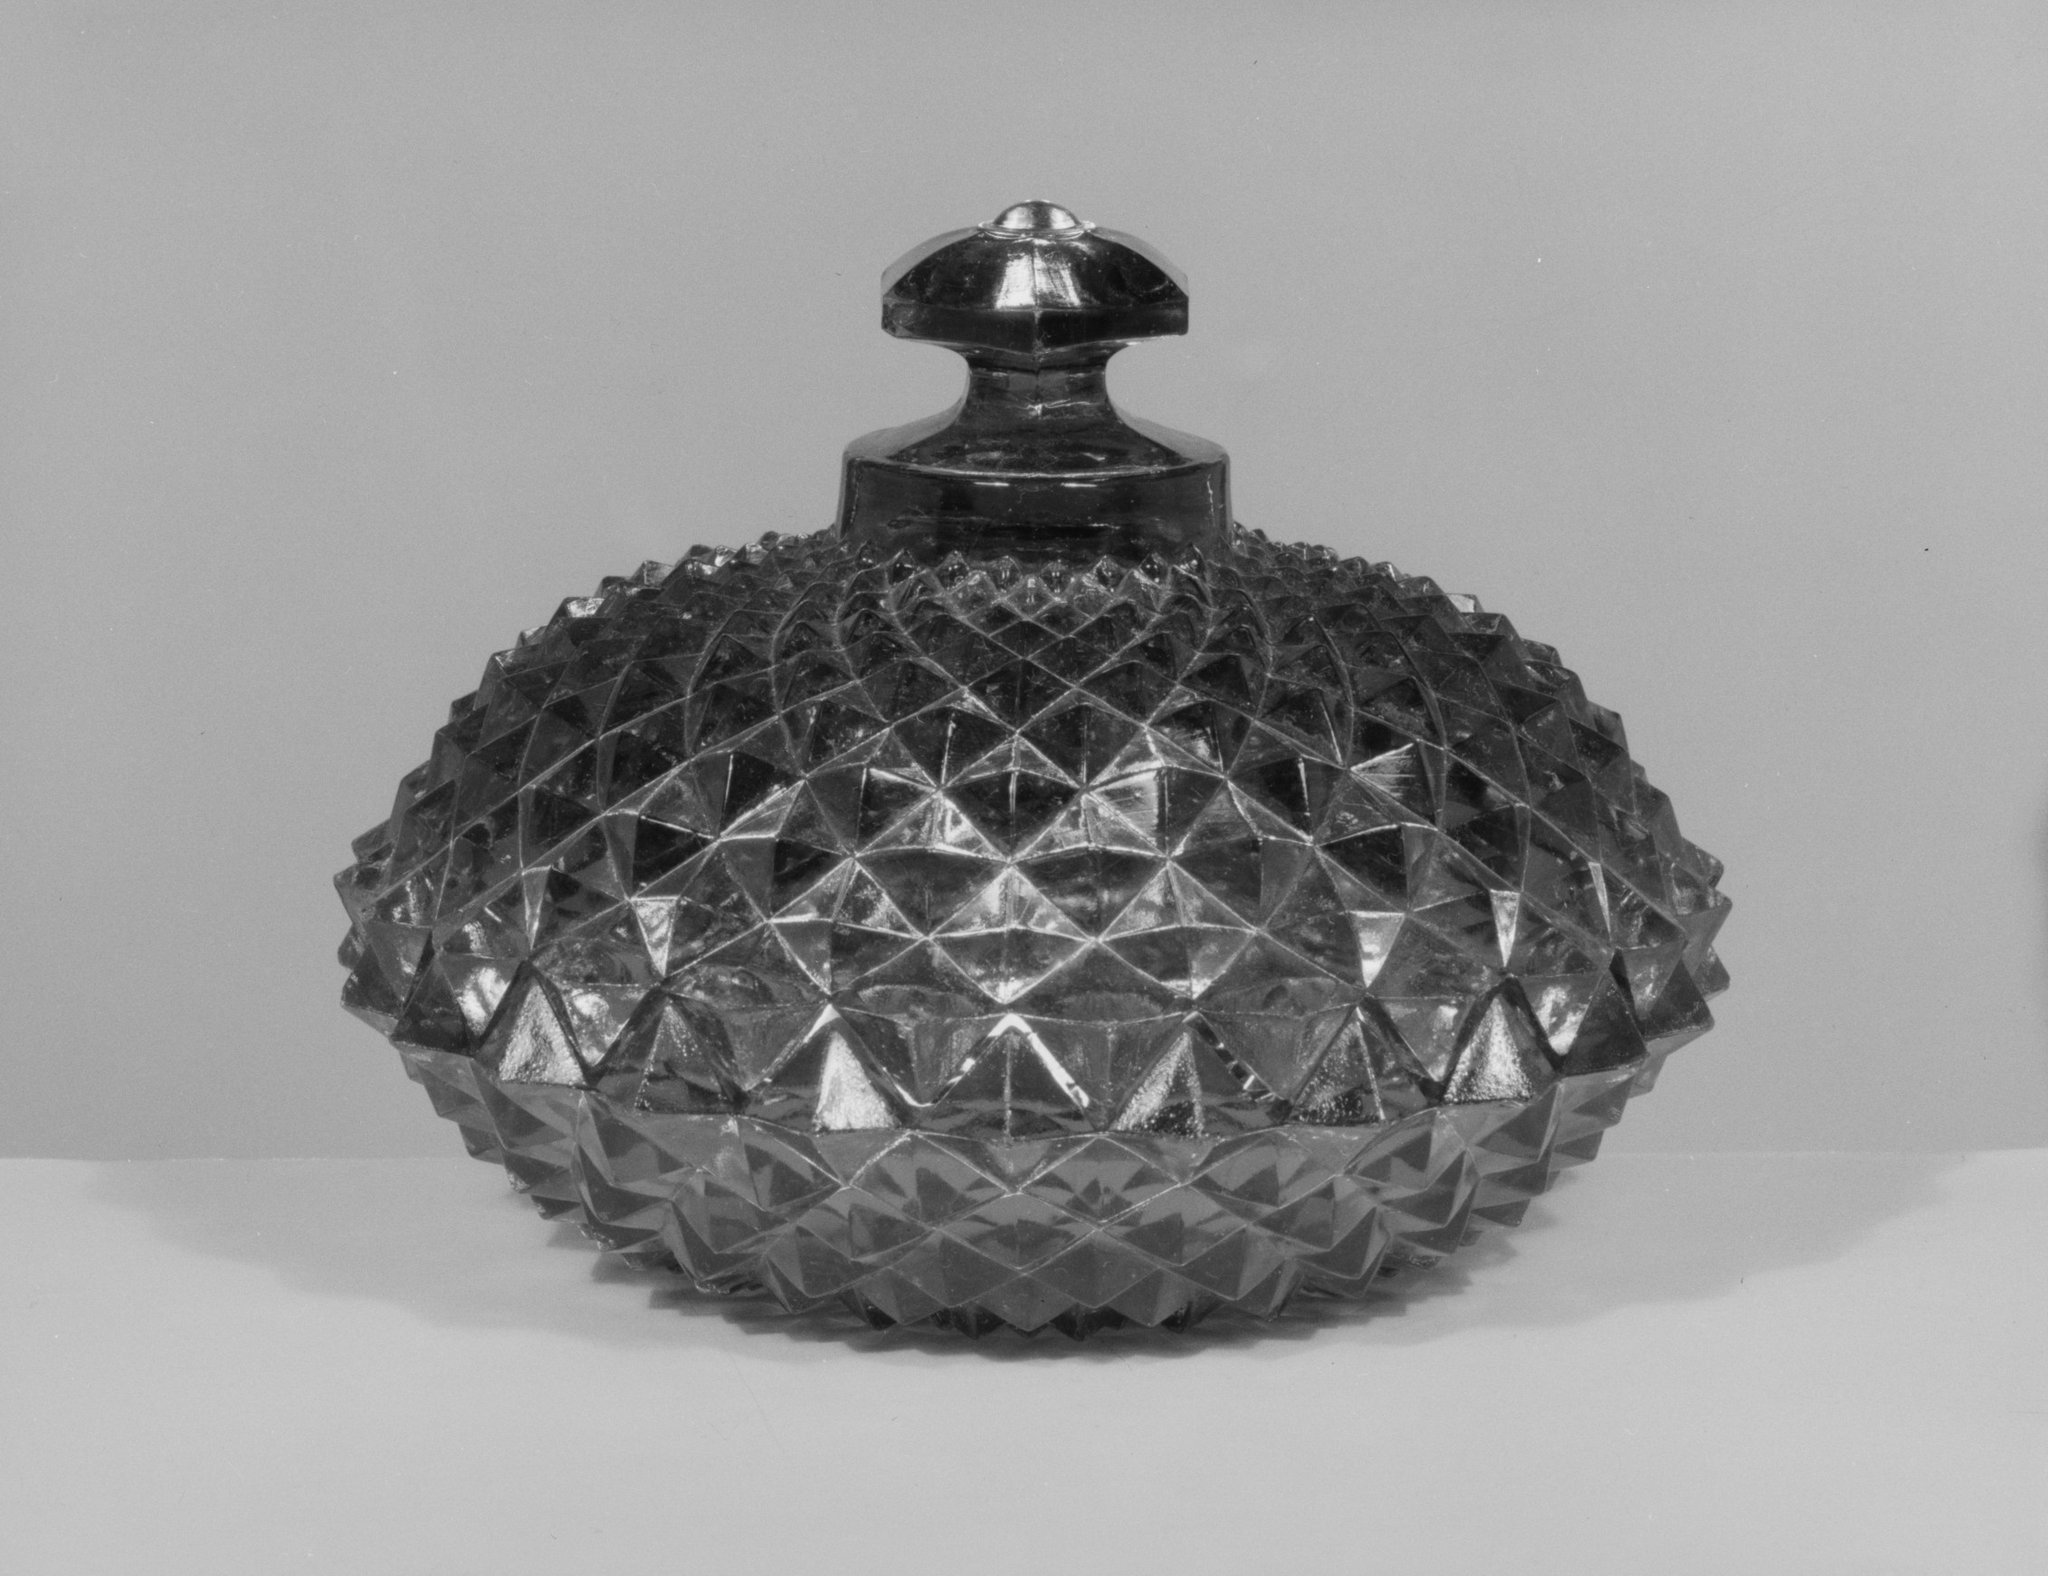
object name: butter dish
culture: american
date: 1870-1885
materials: glass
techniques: pressed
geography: united states